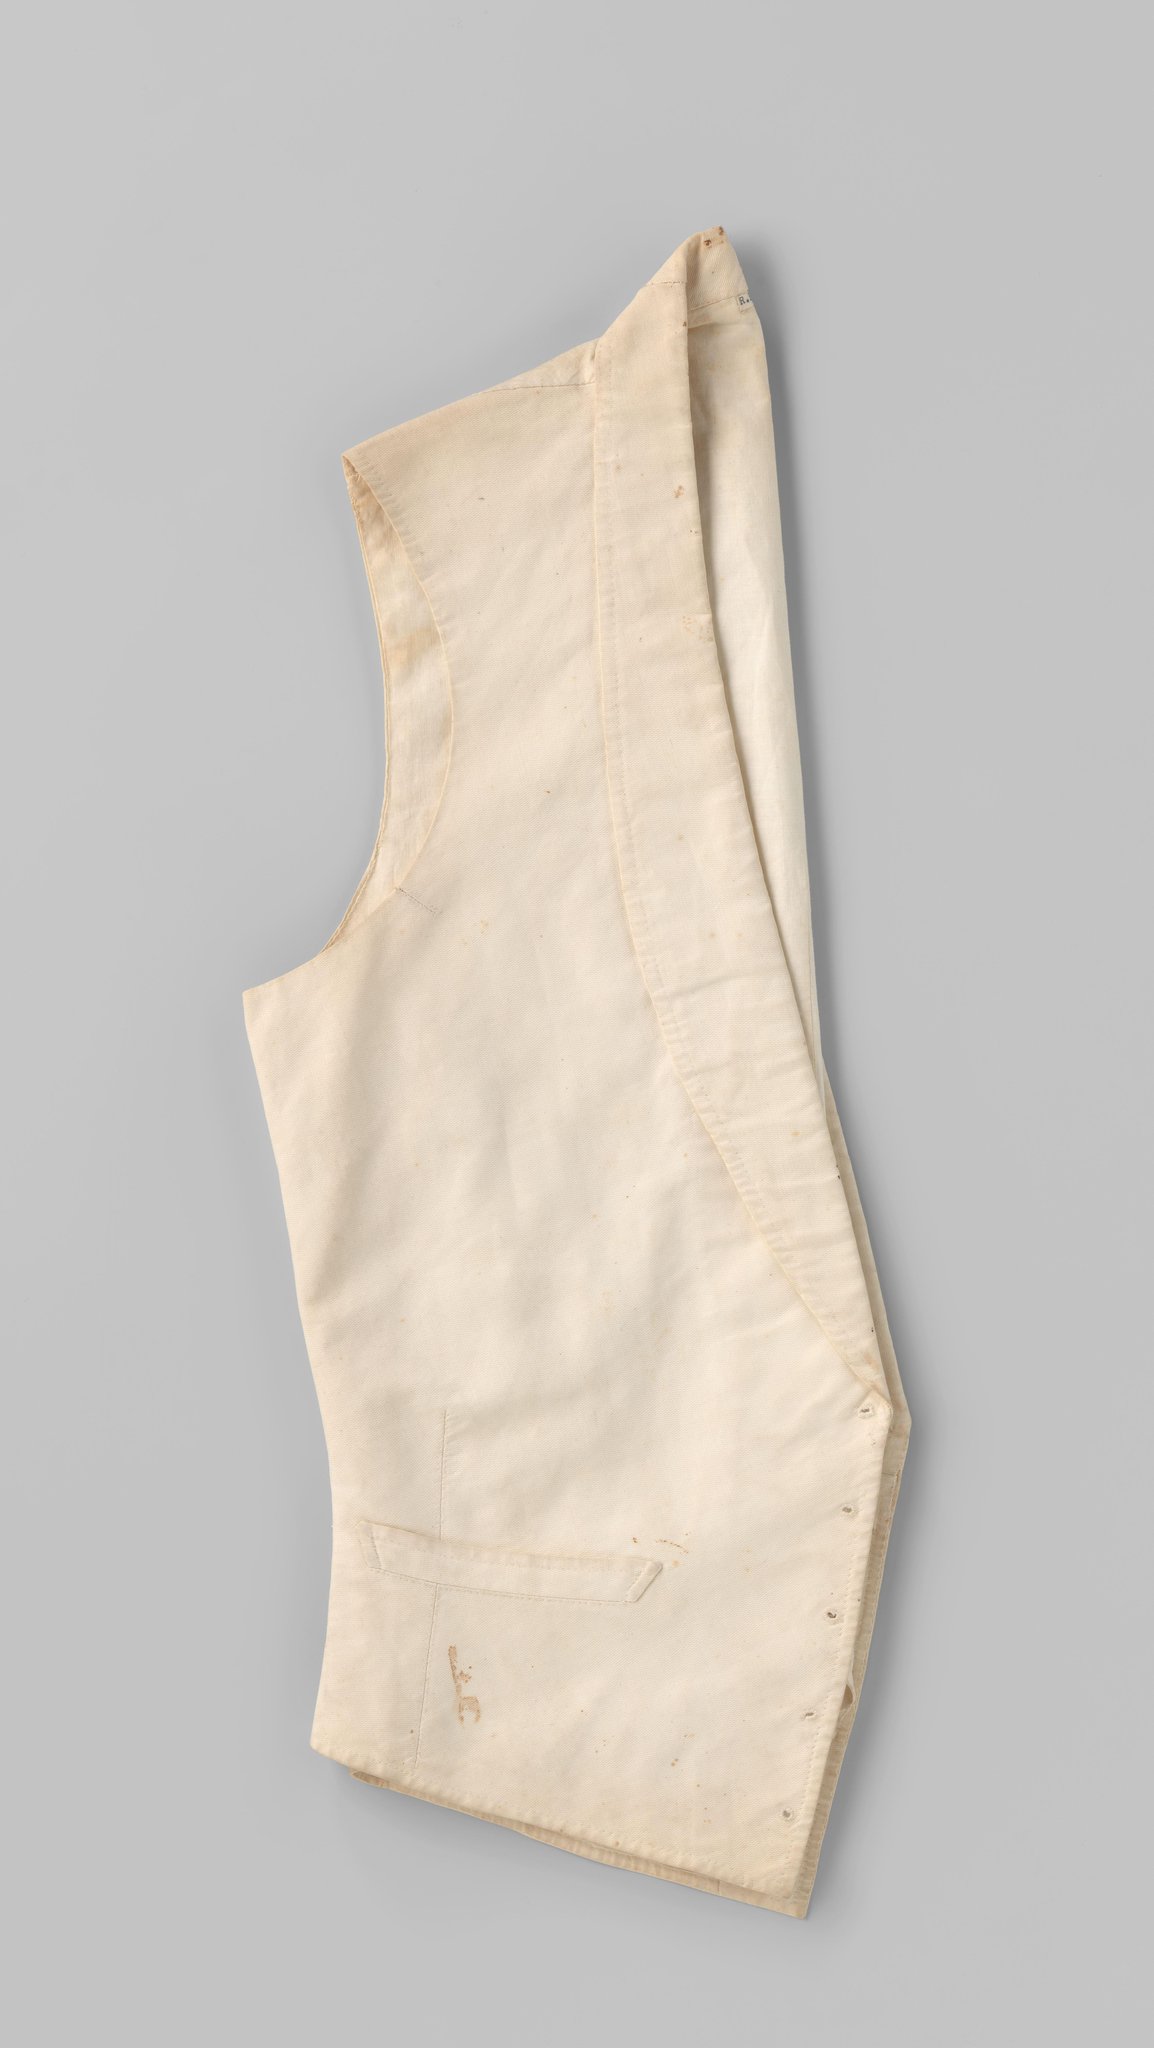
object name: vest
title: Vest met drie insteekzakken, waarvan de bovenste schuingeplaatst, tweemaal vijf knoopsgaten en diep doorlopende sjaalkraag van wit piqué; witte katoenen voering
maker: Anonymous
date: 1800-1815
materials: cotton, textile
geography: netherlands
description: Vest van fijn wit piqué. Met lange platte kraag. In het rechter voorpand één, in het linker twee zakjes. Voering en rugpanden van wit katoen.